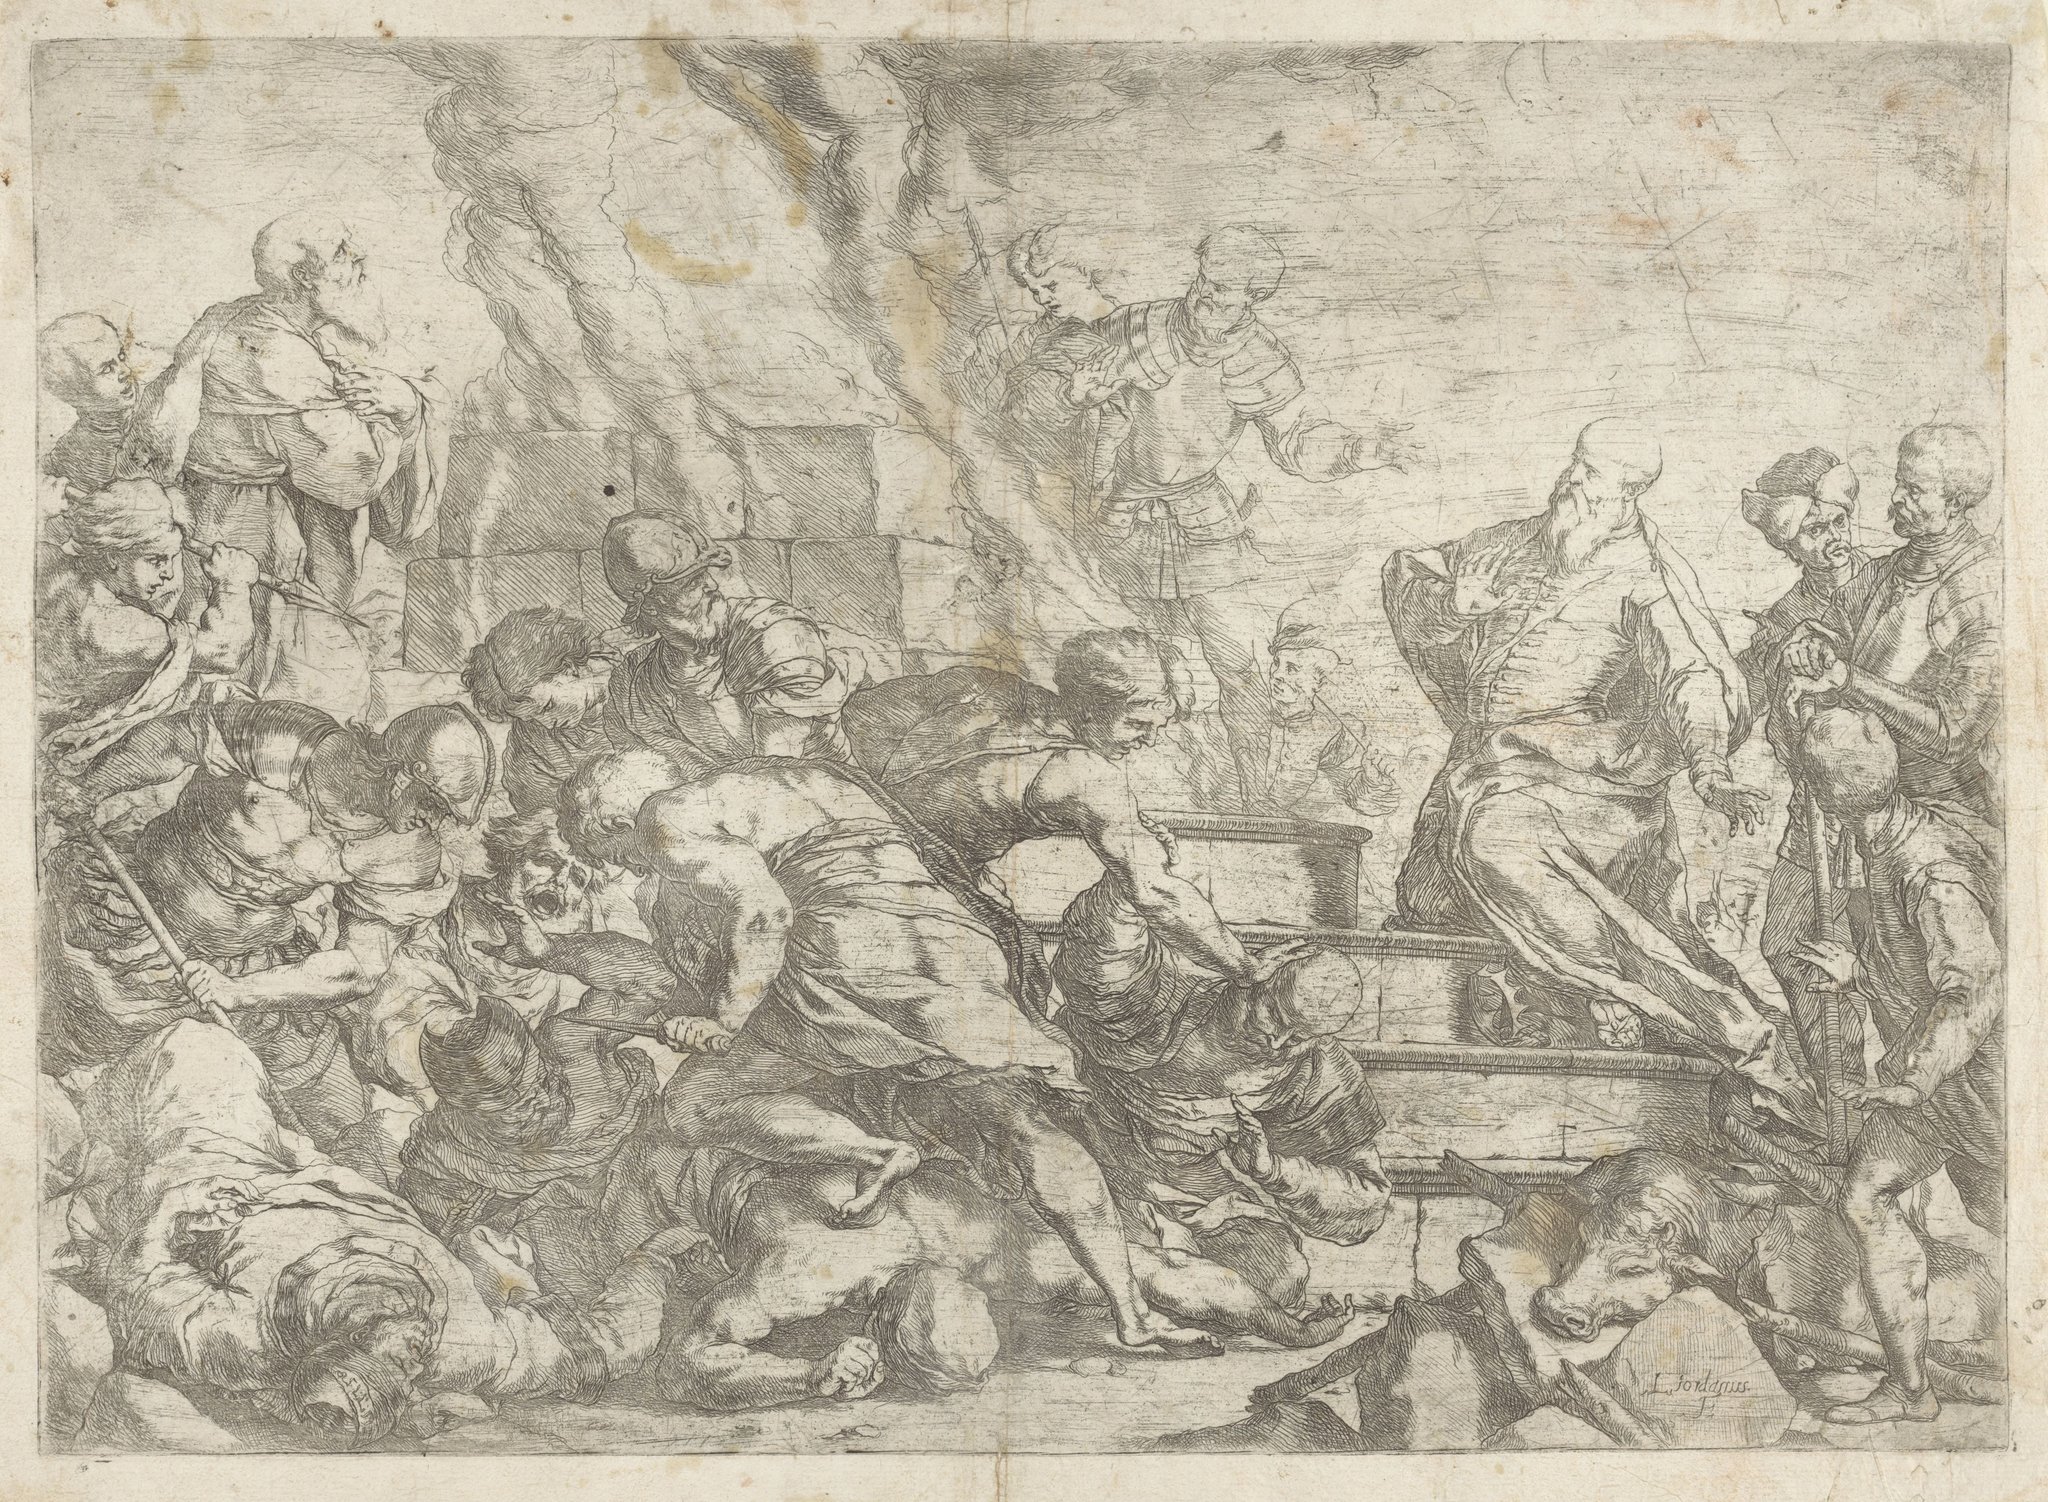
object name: print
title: Offer van Elia door vuur verteerd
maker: luca giordano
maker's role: draughtsman, painter, print maker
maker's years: 1632-1705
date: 1644-1705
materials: paper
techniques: etching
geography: italy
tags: as elijah prays, god sends fire which burns up not only his sacrifice but also the altar itself; the people fall prostrate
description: Het offer van Elia aan God brandt op een altaar. Ook het altaar zelf staat in brand. Soldaten doden de priesters van Baäl op de voorgrond.